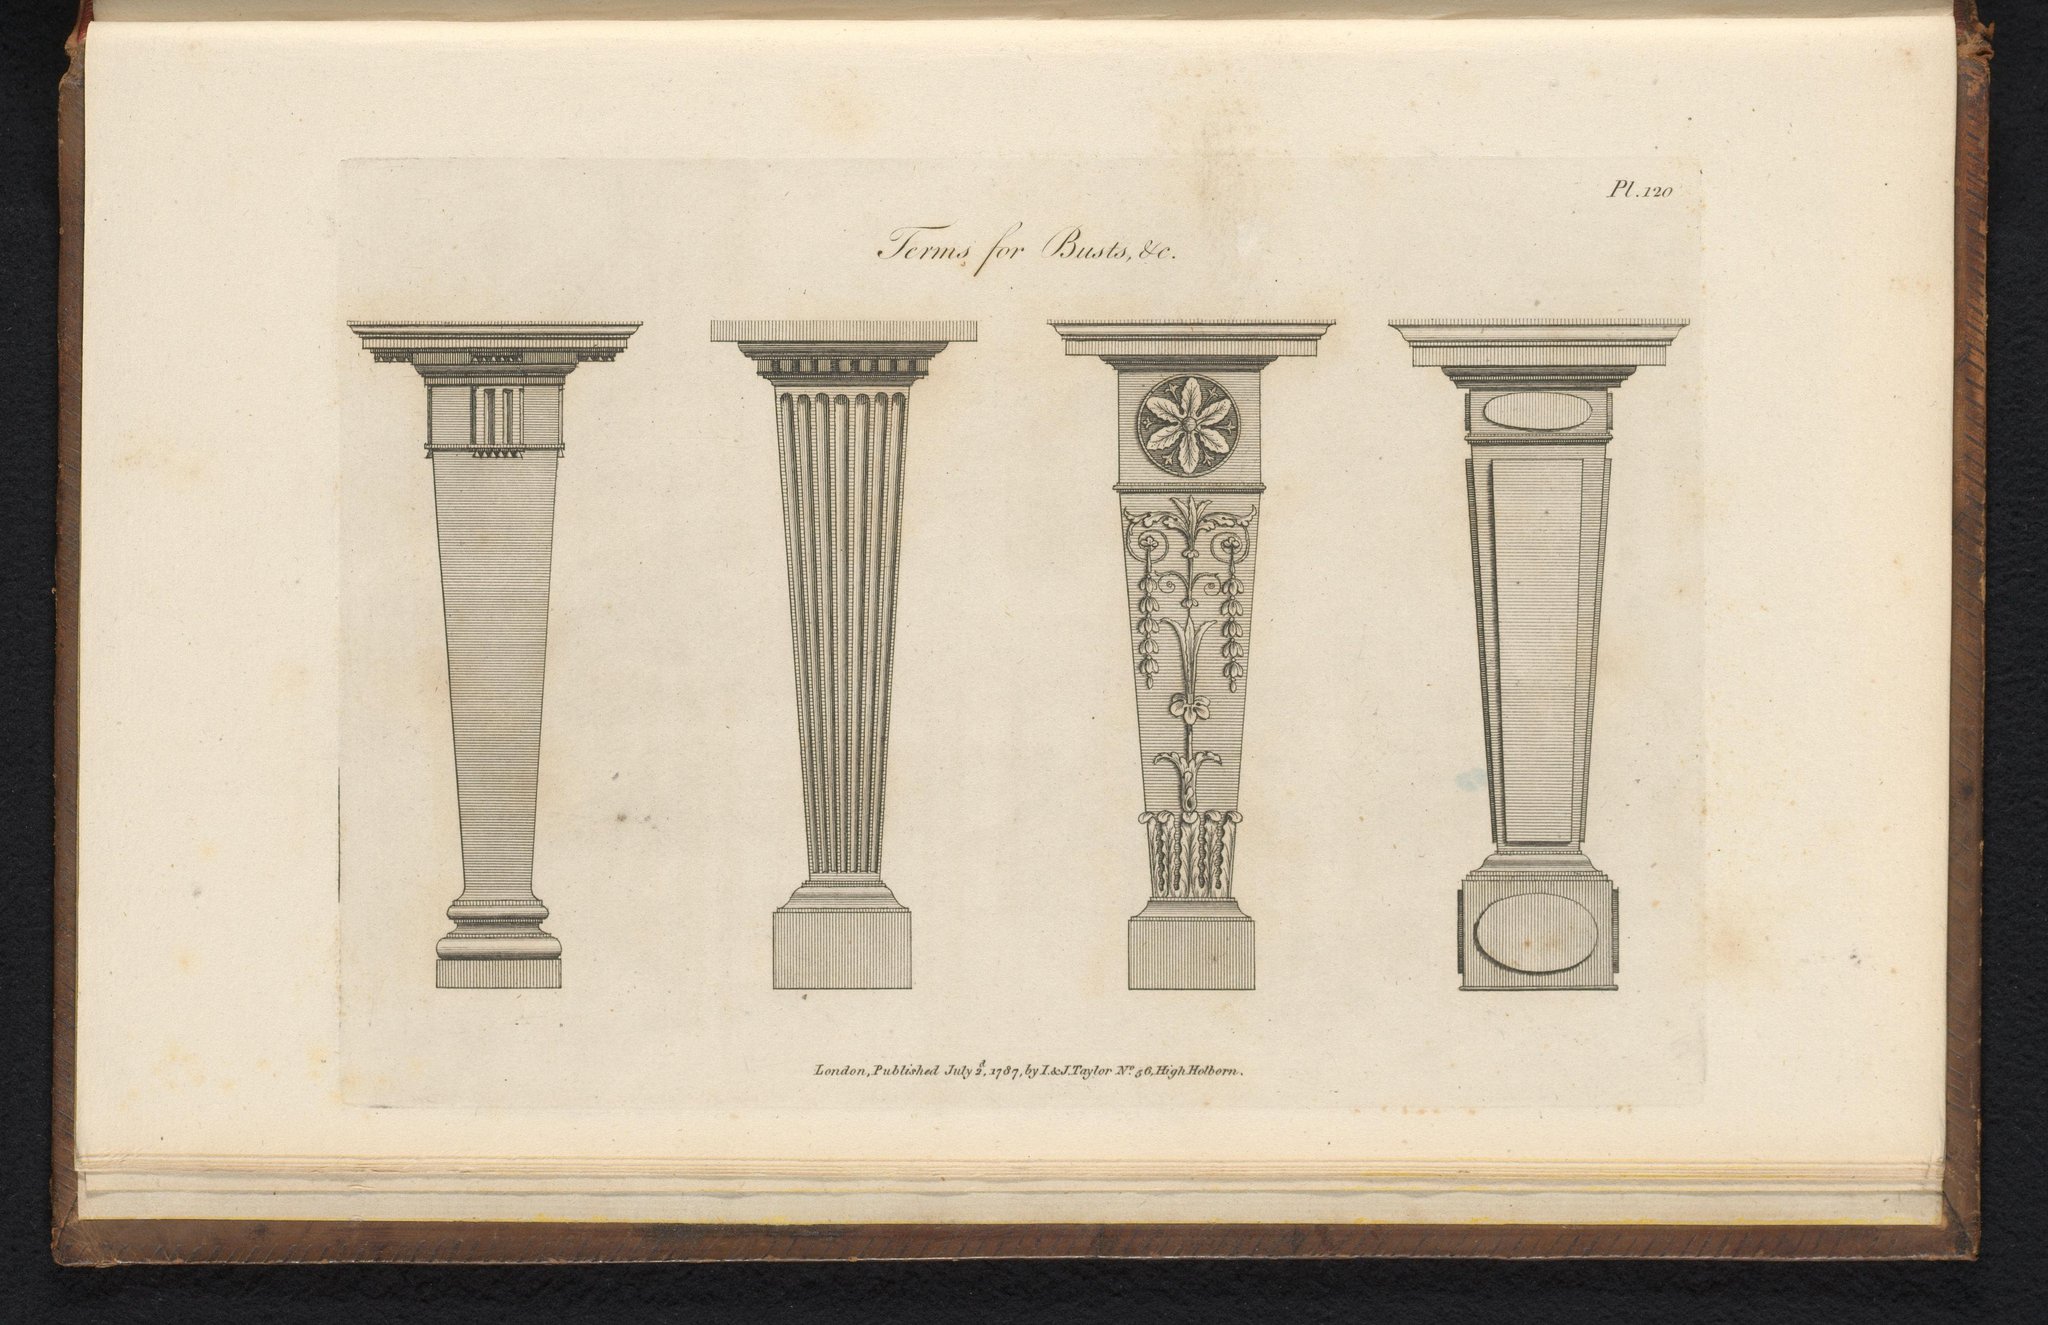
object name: print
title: Terms for Busts, &c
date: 1787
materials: paper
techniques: engraving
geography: holborn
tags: pedestal of a piece of sculpture (perhaps in the form of a herm), sculpture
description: Genummerd: Pl. 120. Prent maakt deel uit van een boek.